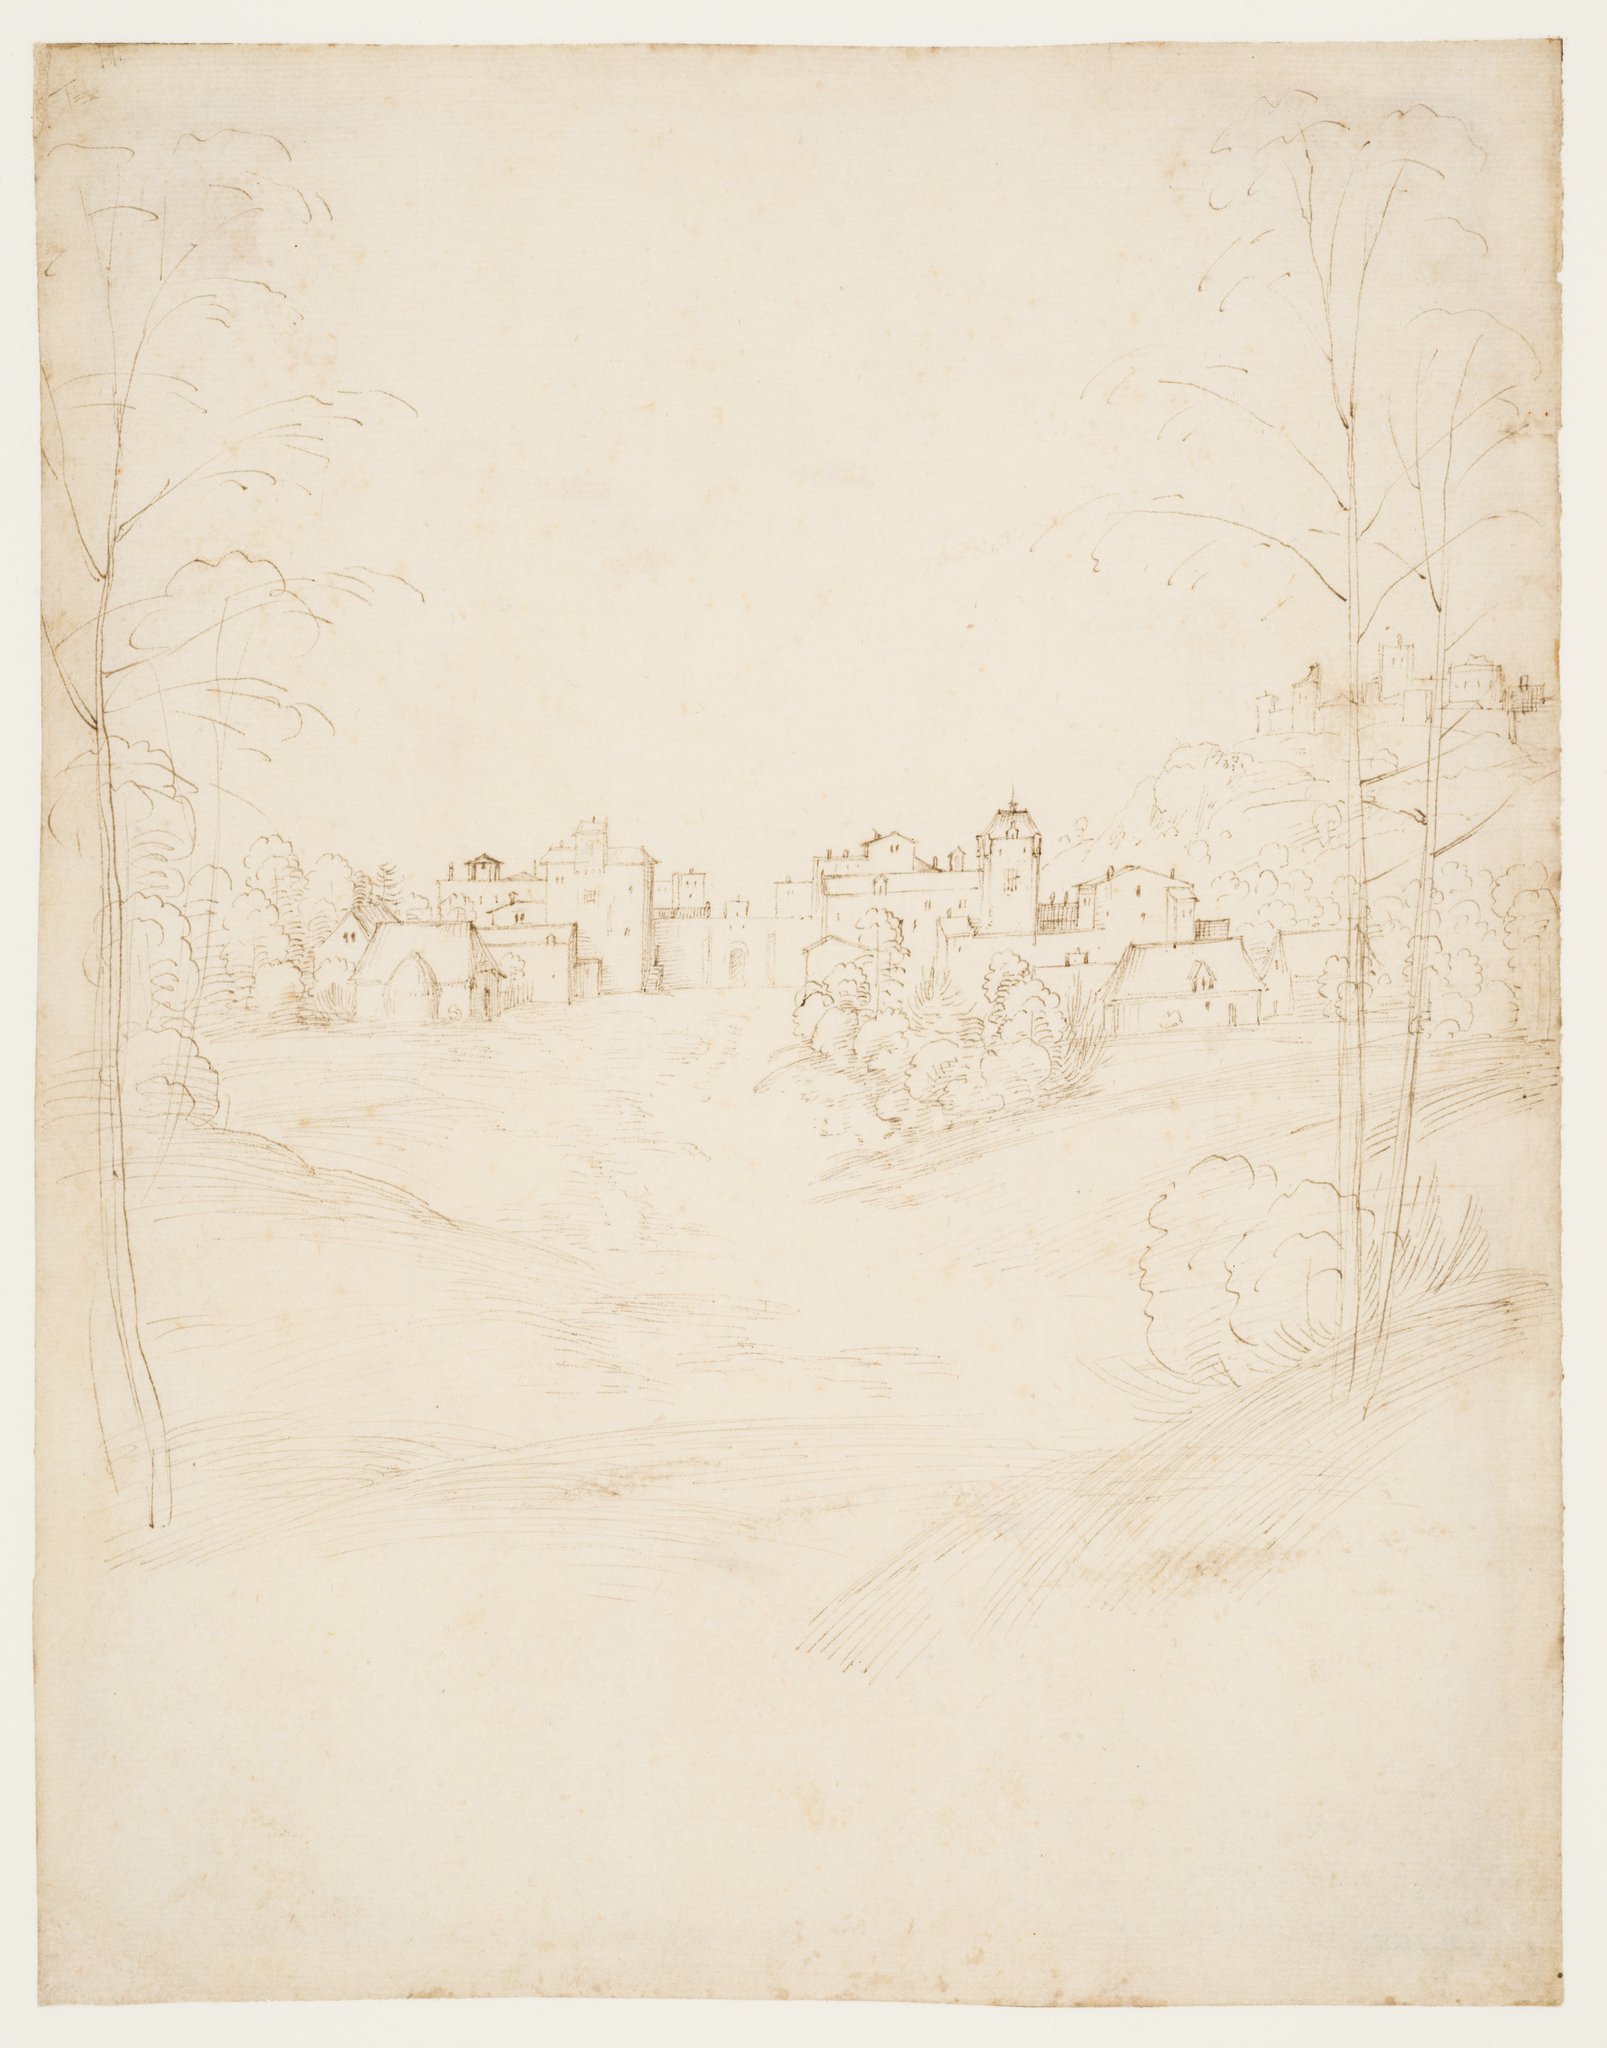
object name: drawing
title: A Small Town on the Crest of a Slope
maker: fra bartolomeo (bartolomeo di paolo del fattorino)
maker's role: artist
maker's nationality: italian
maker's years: 1473-1517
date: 1504-1507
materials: ink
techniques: pen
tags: buildings,towns